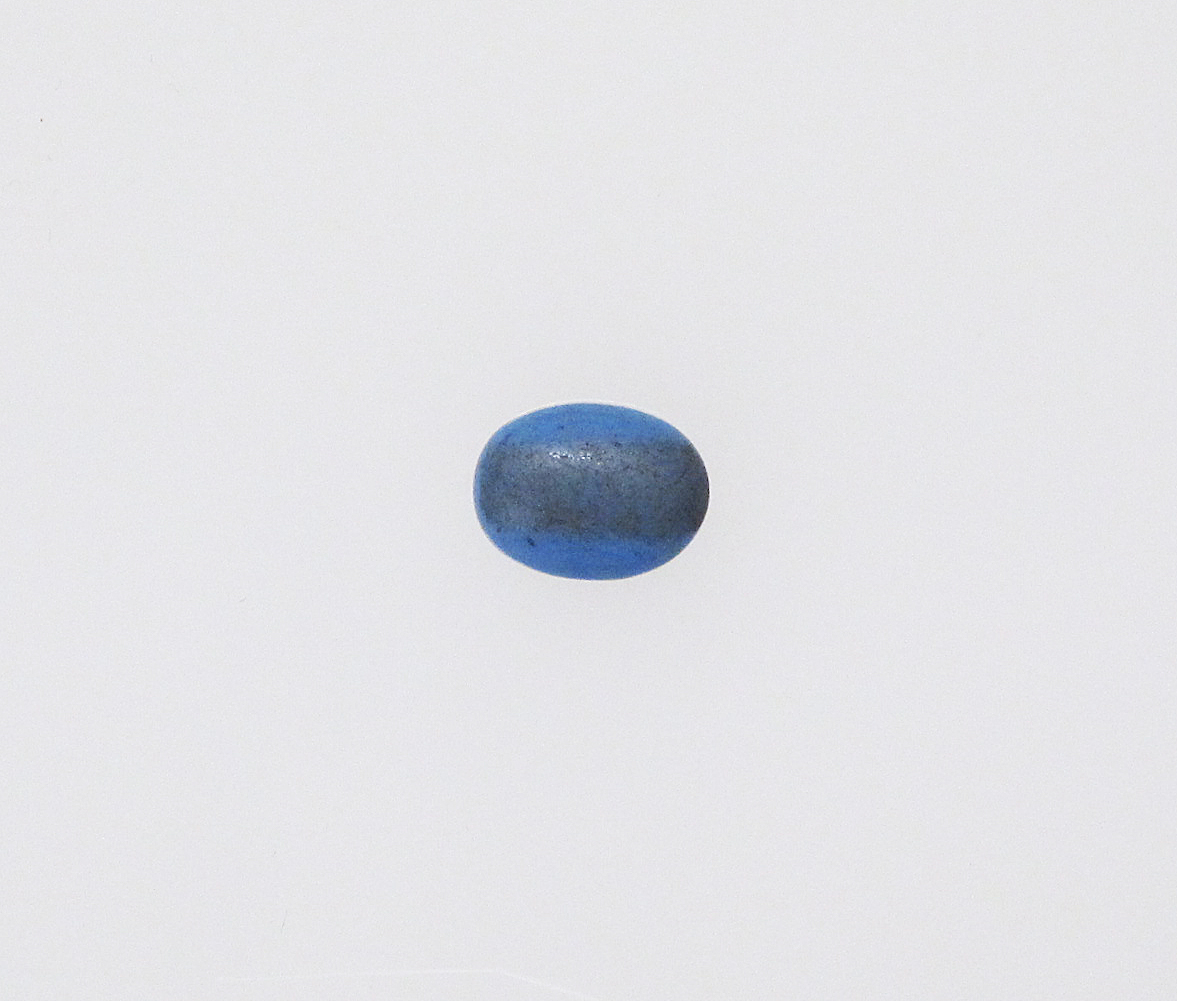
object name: ornament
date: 7000 BCE-330 CE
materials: glass